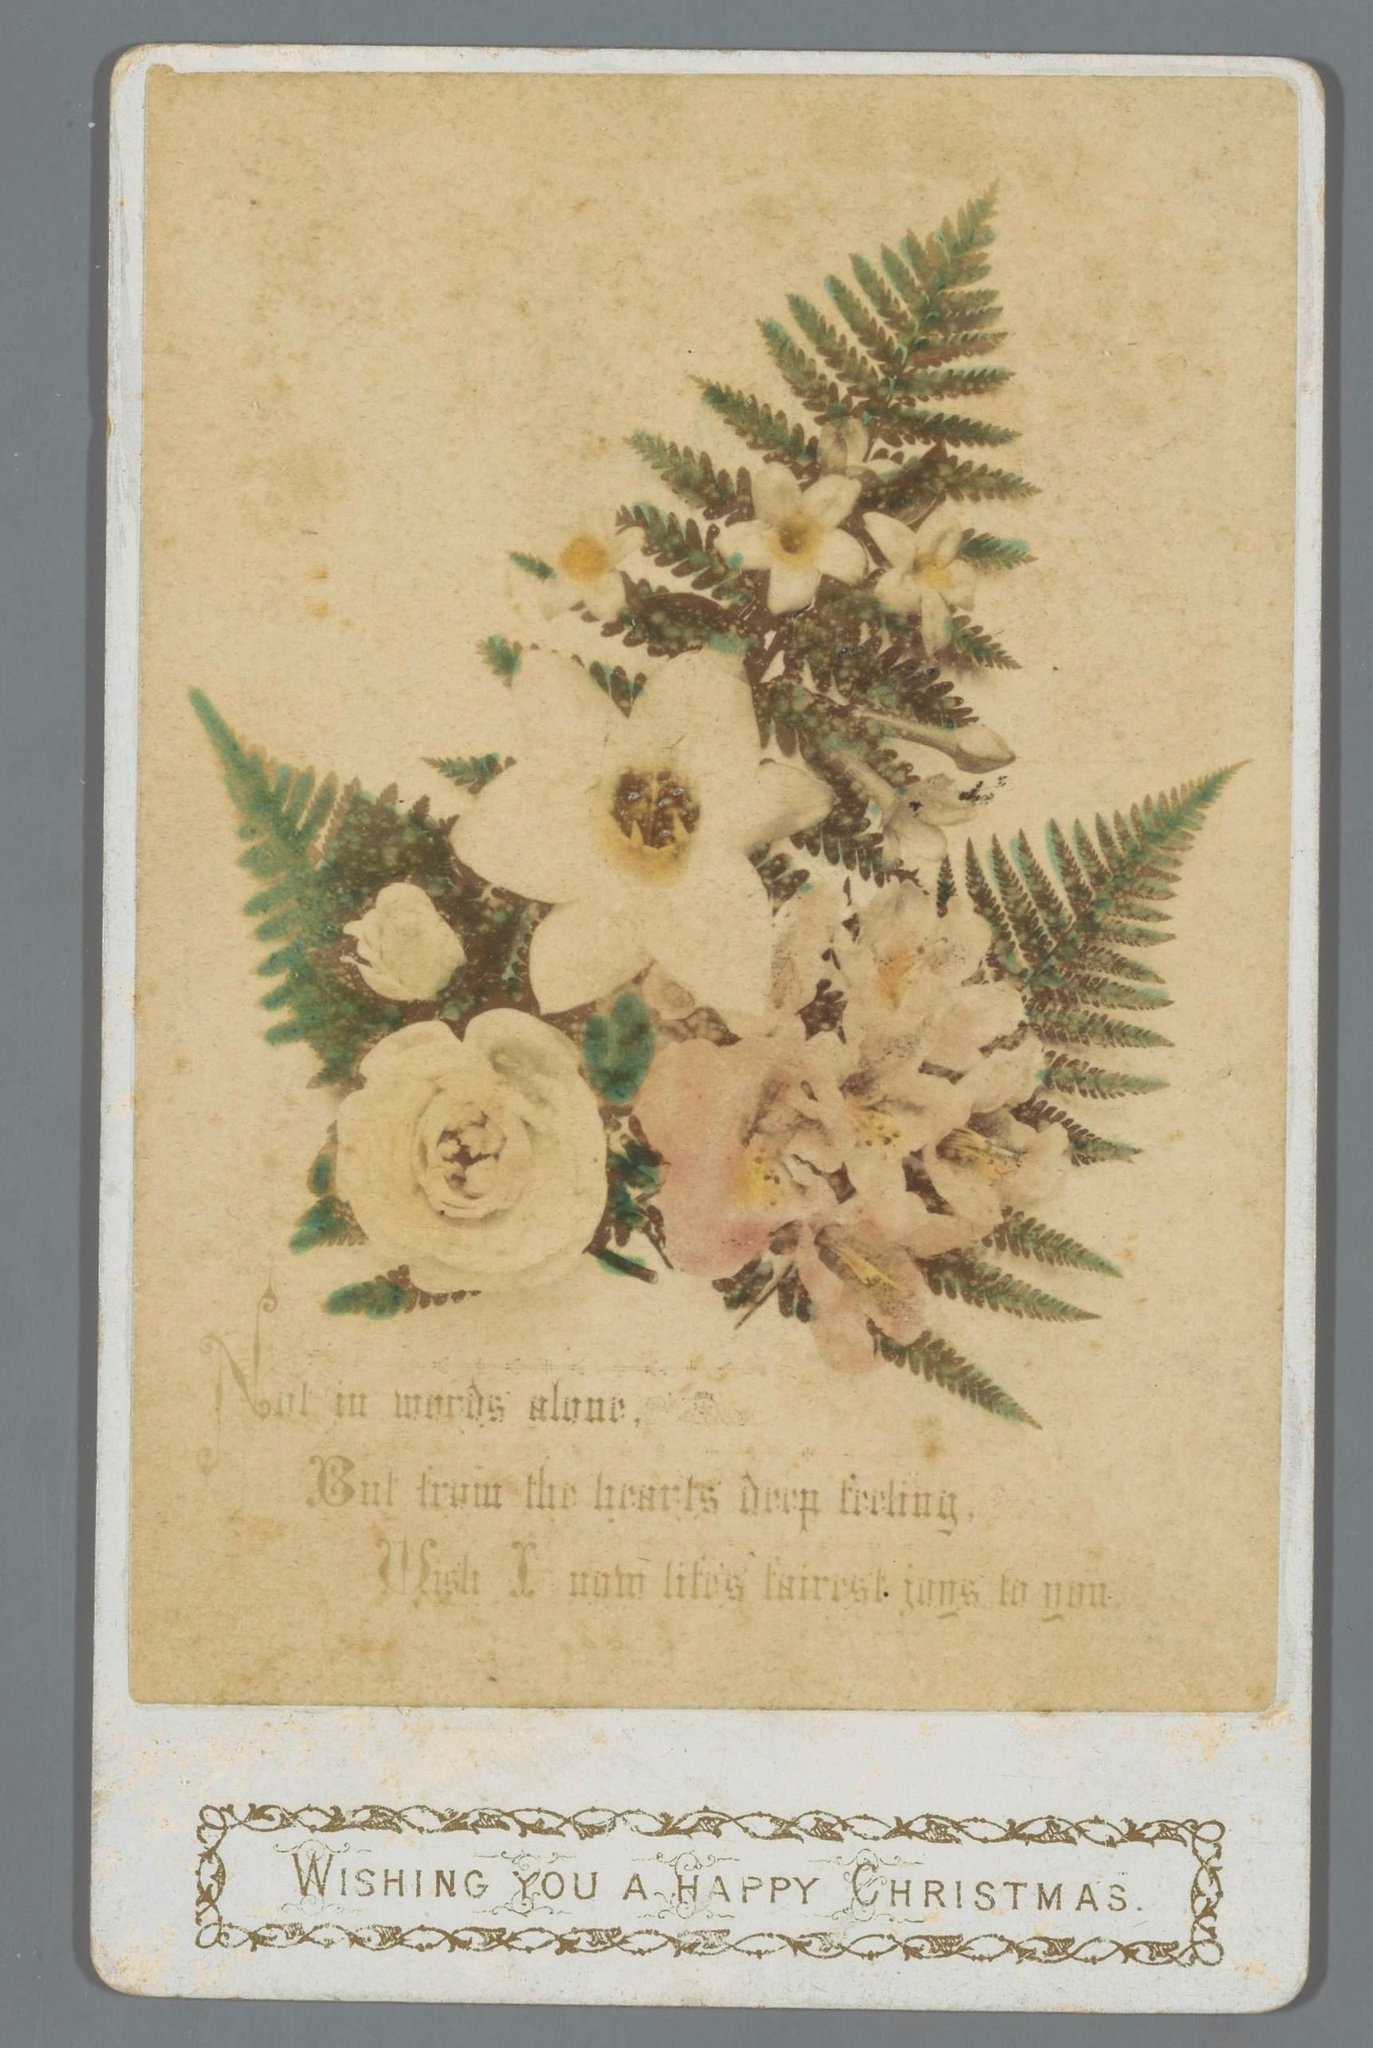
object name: photograph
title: Kerstgroet (stilleven van bloemen en varens en de tekst ‘WISHING YOU A HAPPY CHRISTMAS’)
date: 1880-1890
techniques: albumen print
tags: cut flowers; nosegay, bunch of flowers